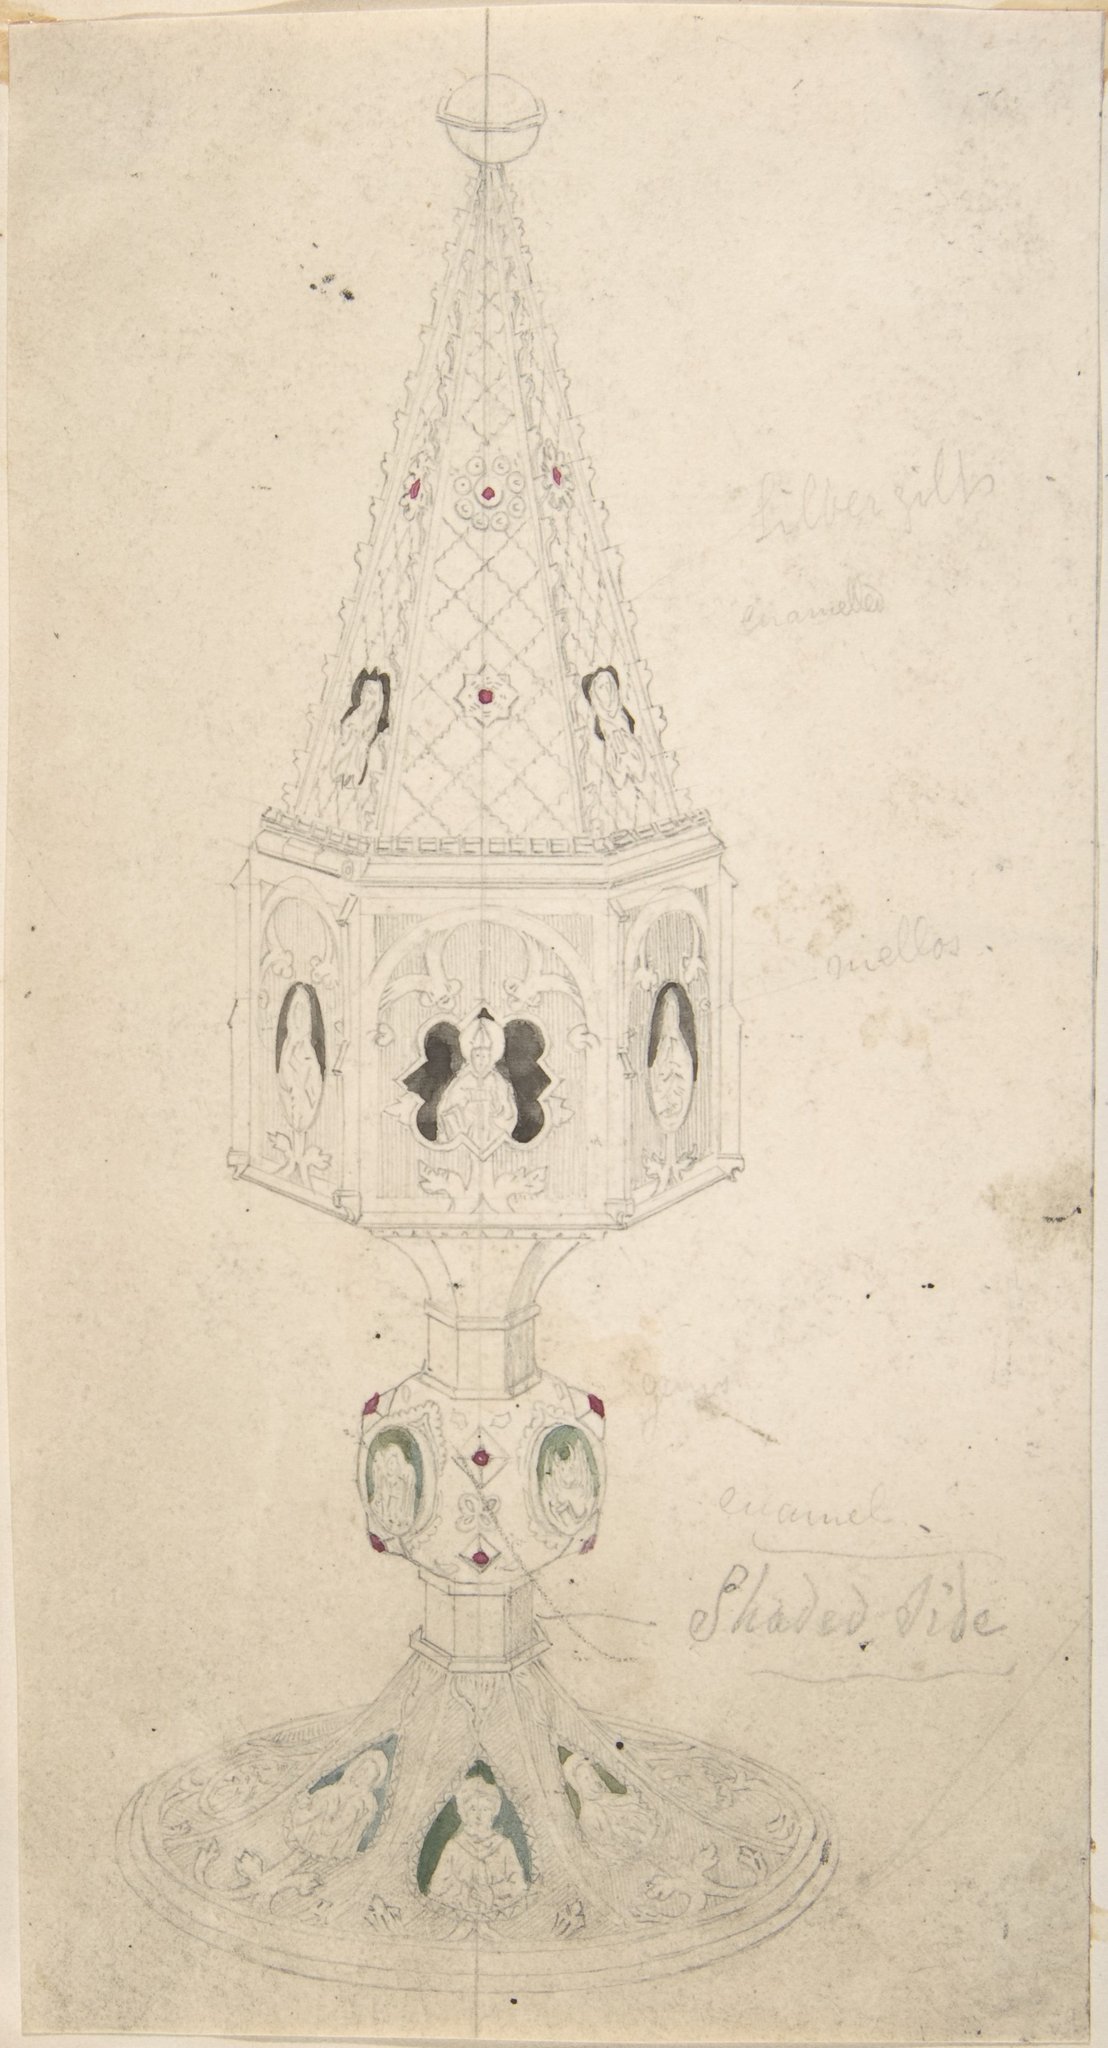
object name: drawing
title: Liturgical Box with Enamelled Ornament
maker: anonymous, british, 19th century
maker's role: artist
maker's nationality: british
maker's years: 1800-1900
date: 1851-1900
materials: graphite, ink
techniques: brush, pen, wash